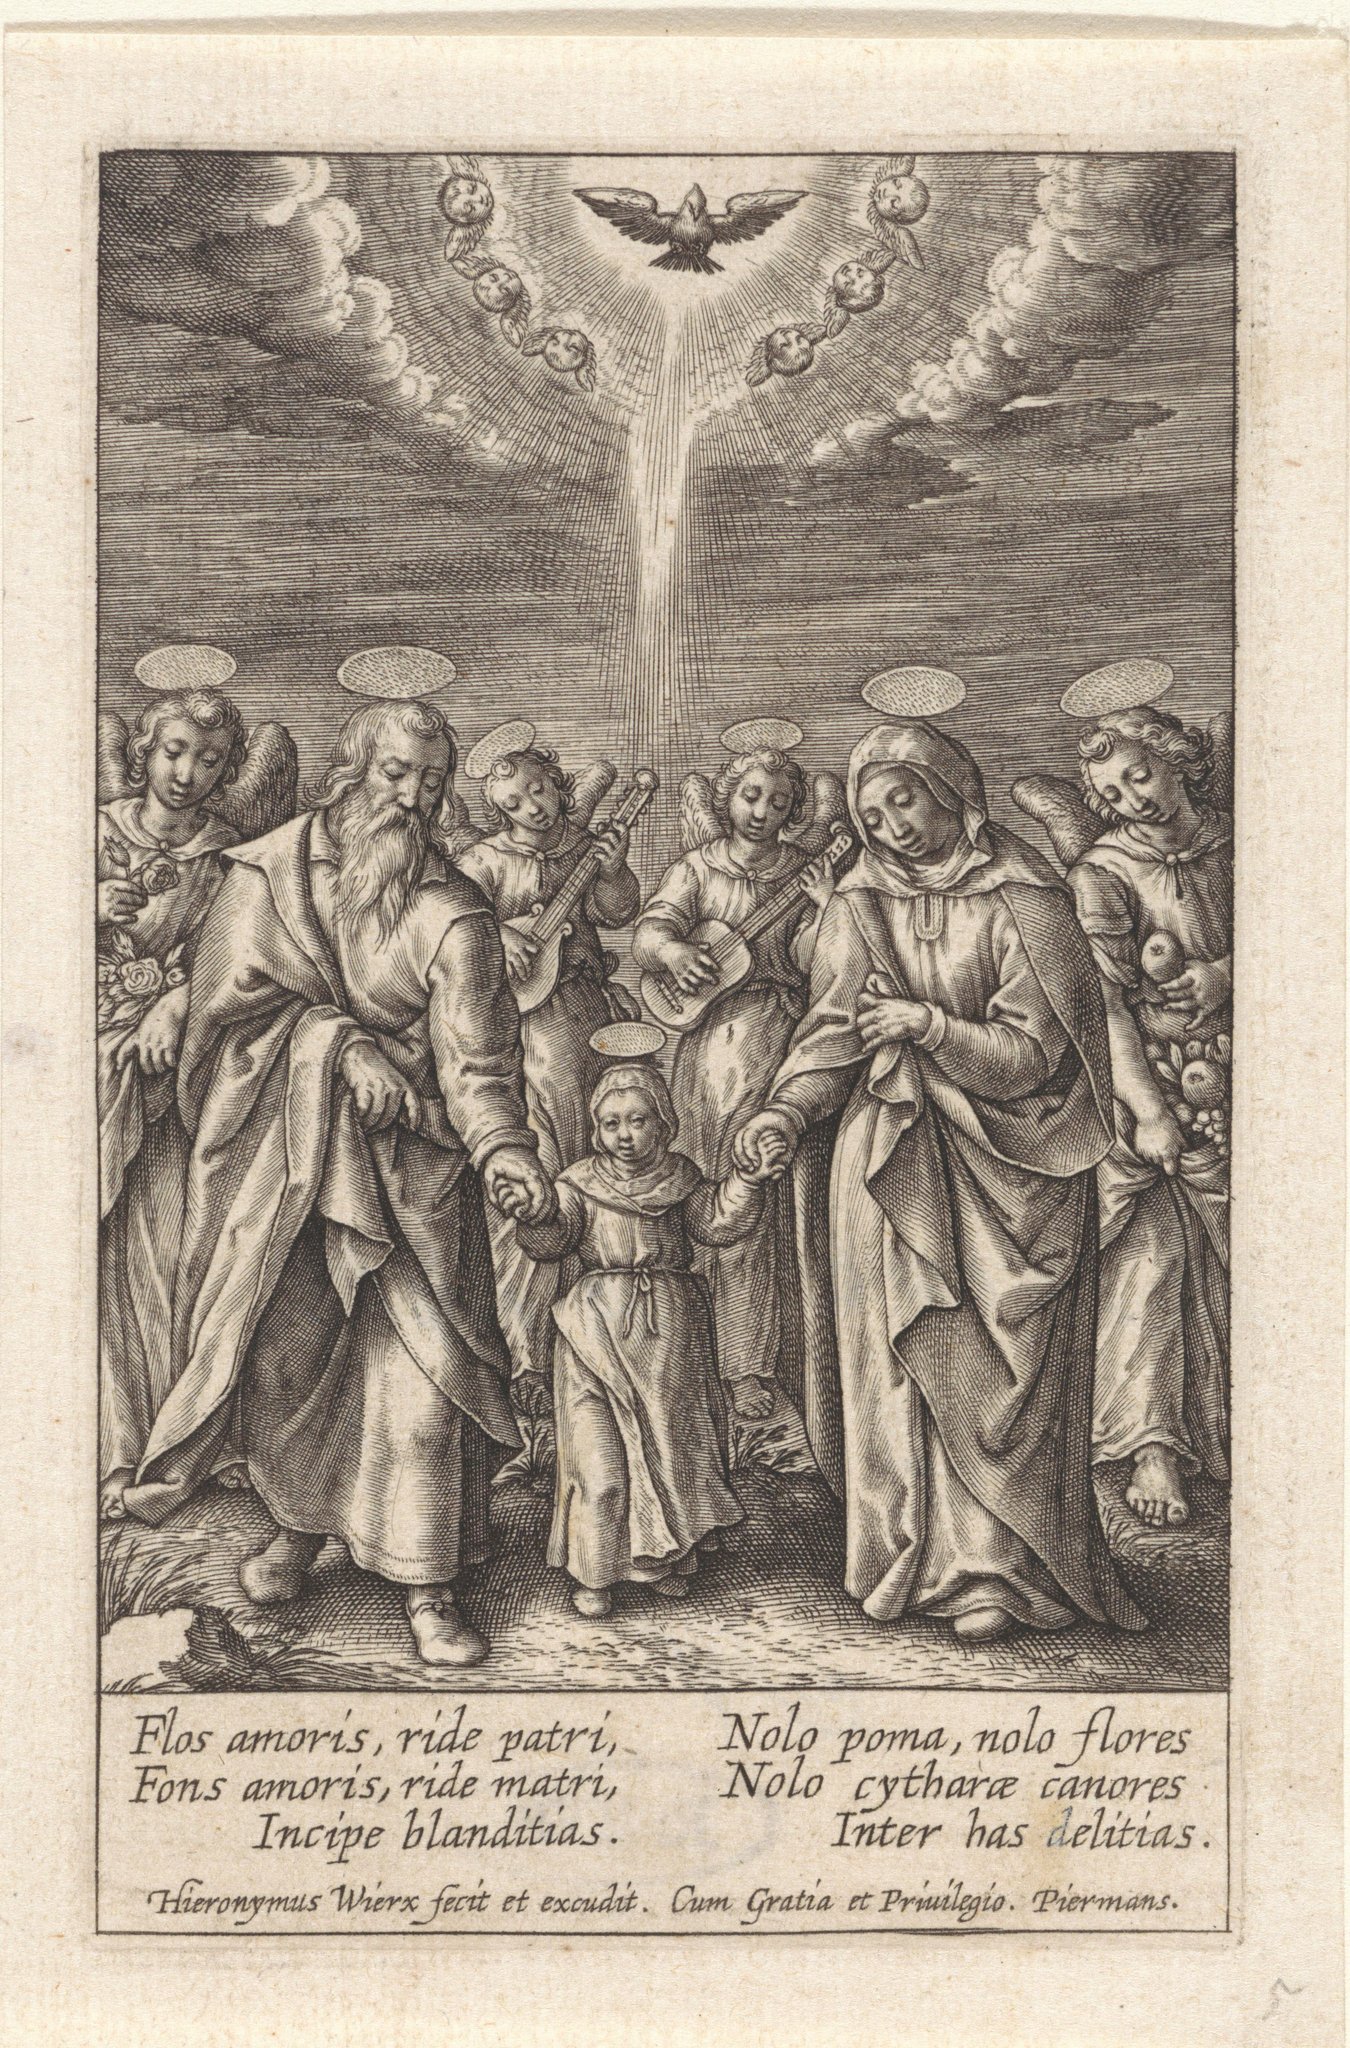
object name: print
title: Vita Deiparæ Virginis Mariæ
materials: paper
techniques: engraving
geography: antwerp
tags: devout mary together with her parents; angels, and perhaps god the father present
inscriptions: collector's mark: Lugt 2228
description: De jonge Maria loopt, hand in hand, tussen haar ouders Joachim en Anna in. Achter hen musicerende engelen, en sommige met bloemen in de hand. Boven hen de Heilige Geest (als duif), omringd door cherubijnen. In de marge een zesregelig onderschrift, in twee kolommen, in het Latijn.